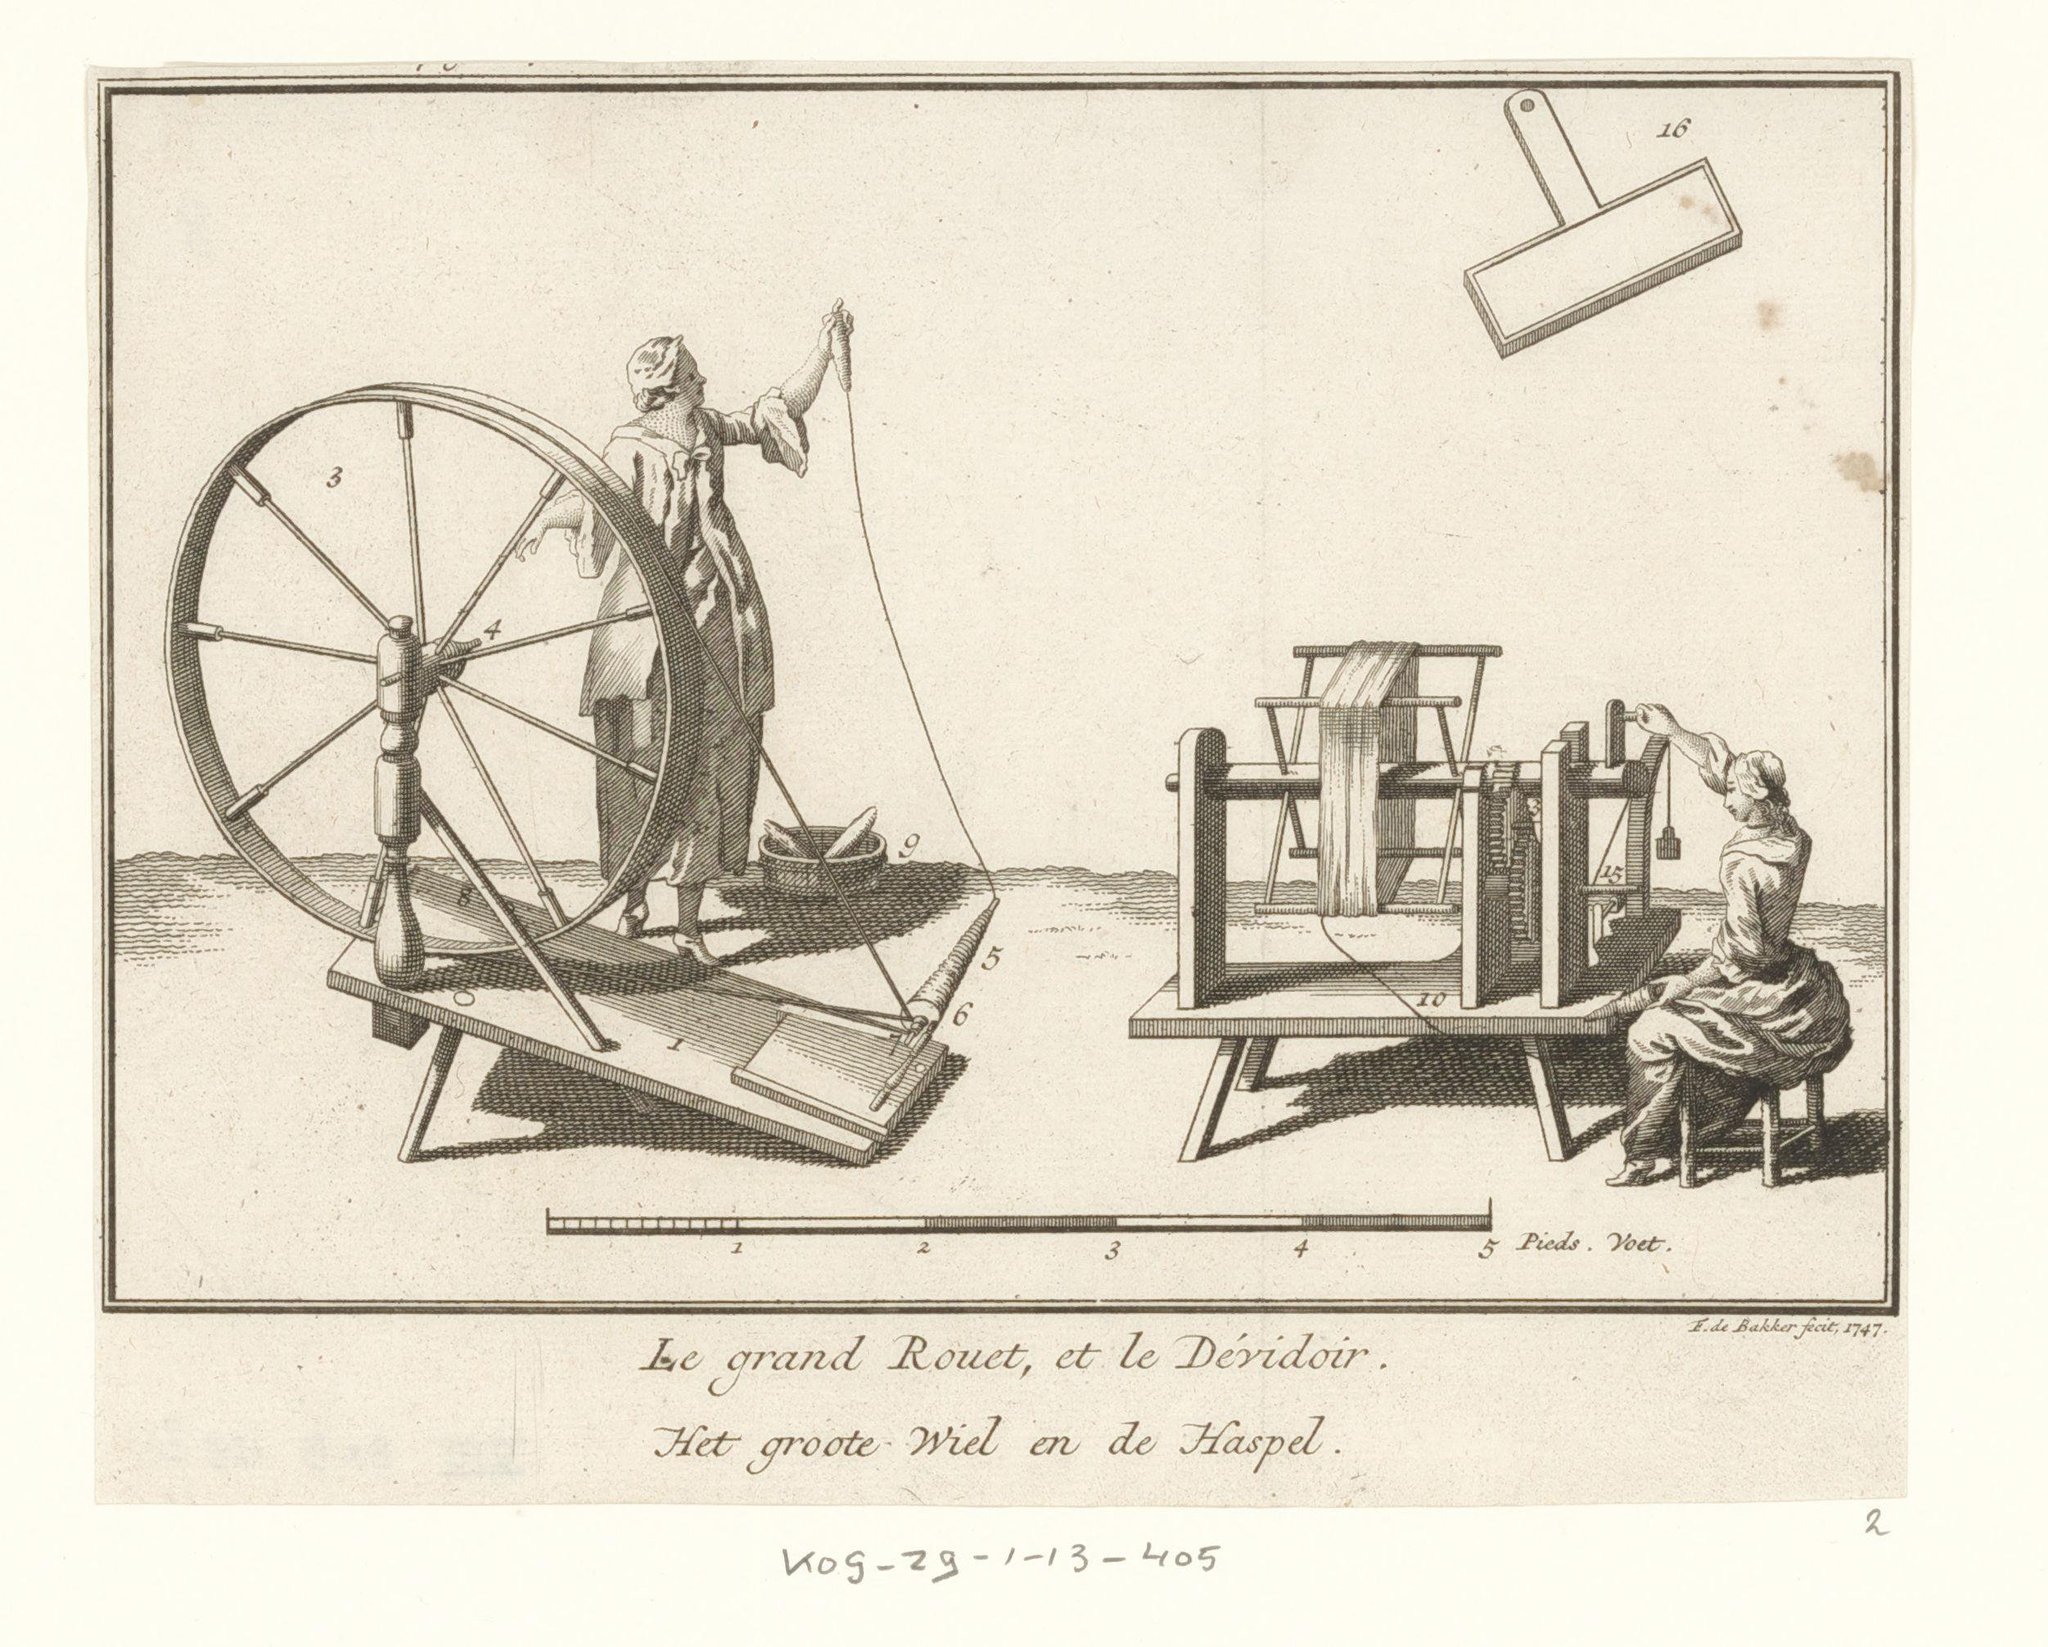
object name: print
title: Groot spinnewiel en haspel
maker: frans de bakker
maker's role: print maker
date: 1747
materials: paper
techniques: engraving, etching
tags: spinning-wheel, spinning (manufacture of yarn), wool (material ~ textile industry)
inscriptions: stamp, collector's mark: Lugt 1641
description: Prent mogelijk uit: Noël-Antoine Pluche. Schouwtoneel der natuur, of Samenspraaken over de Bysonderheden der natuurlyke histori (...). [Vertaald uit het Frans door] Pieter le Clercq. 14 dln. Amsterdam: Salomon Schouten, 1737-1749, dl. 12, na p. 284.